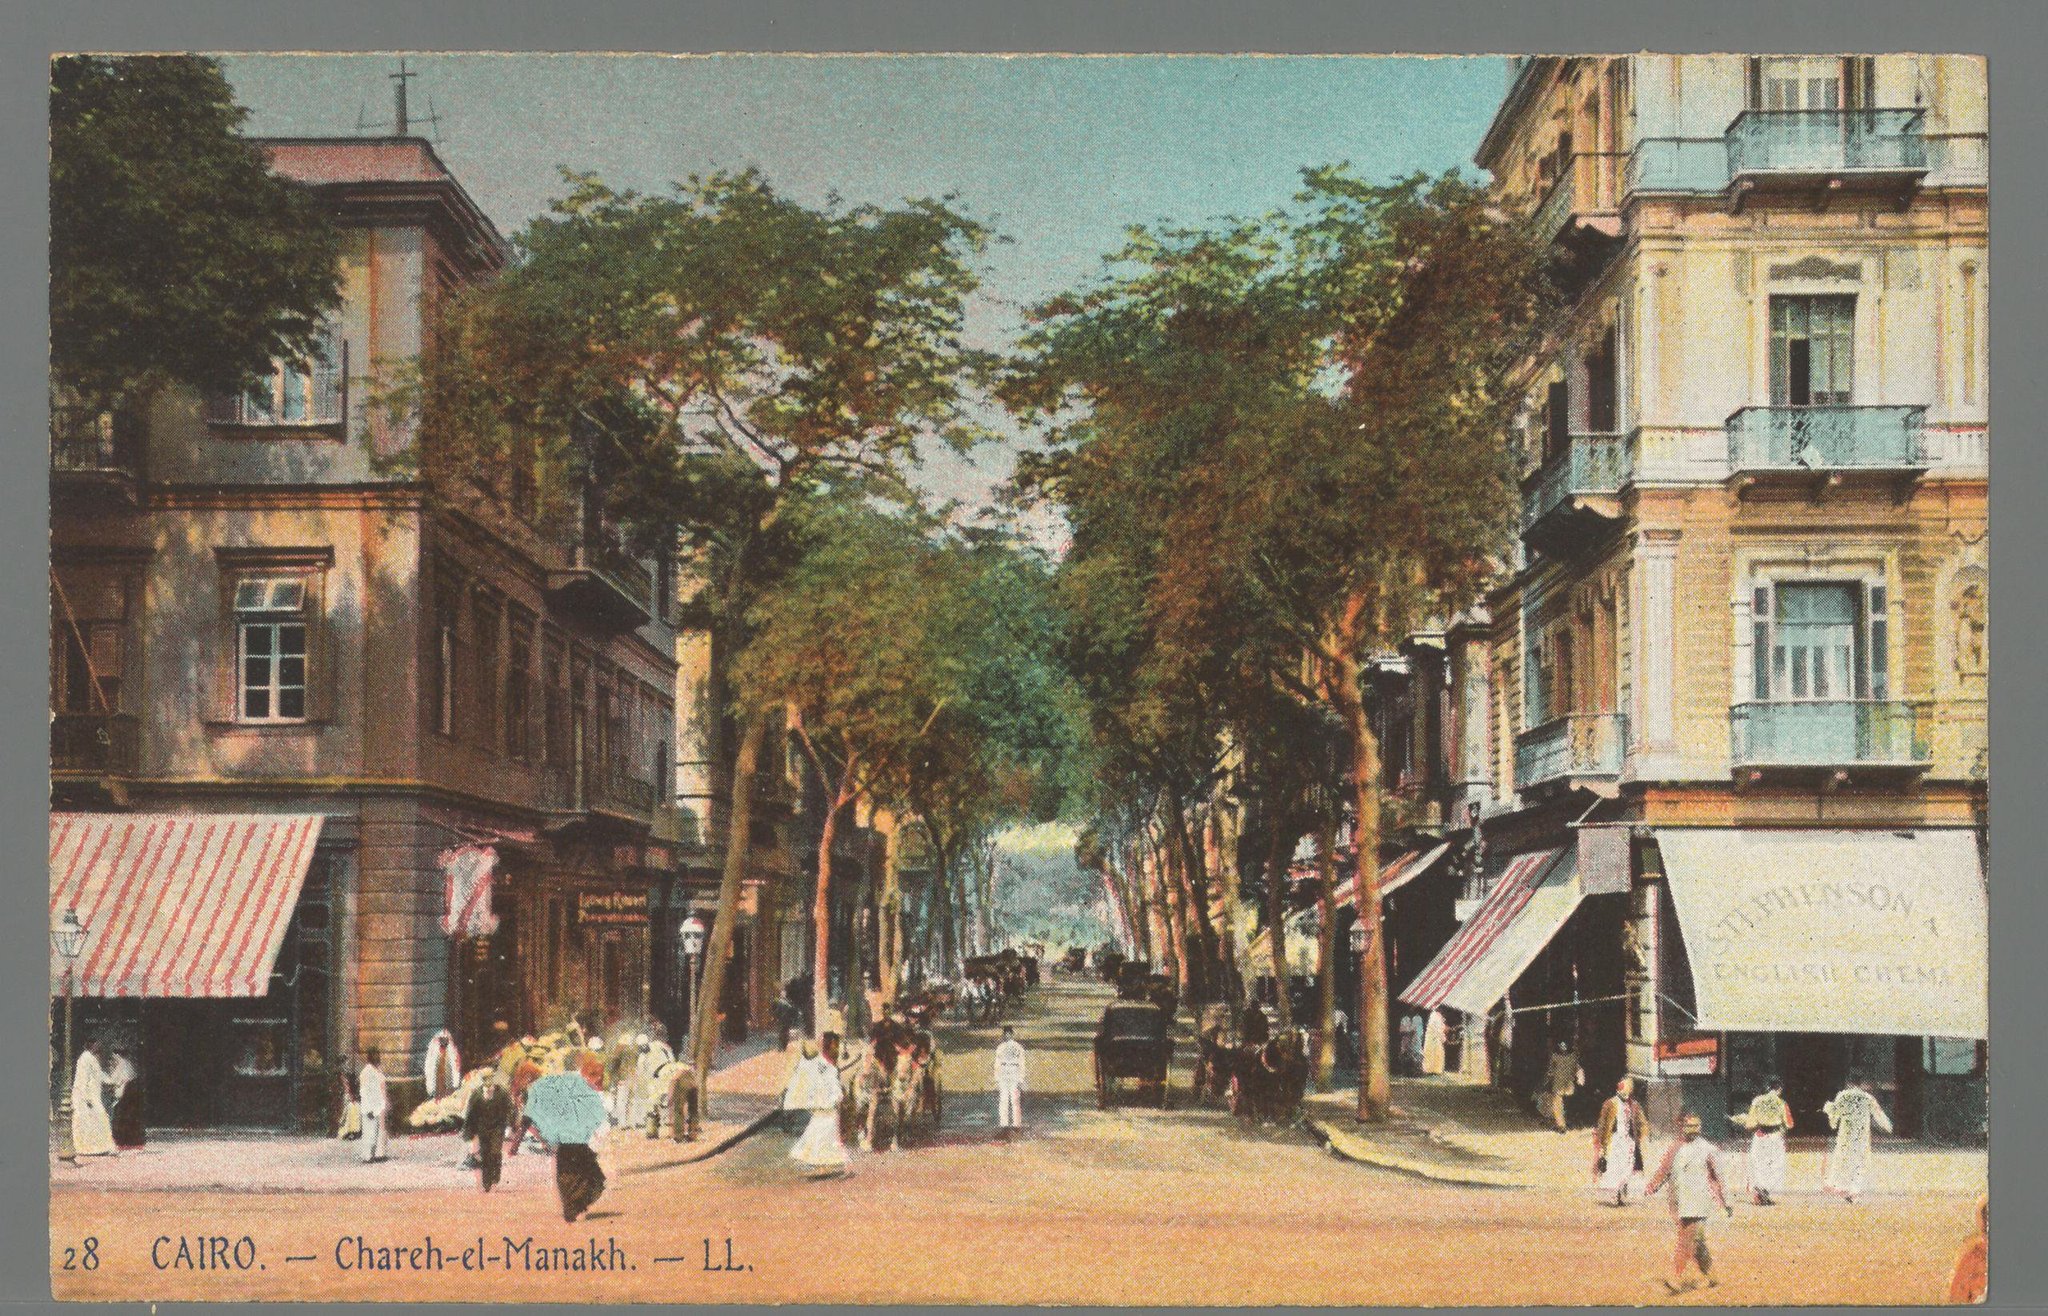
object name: photomechanical print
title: Cairo - Chareh-el-Manakh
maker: Anonymous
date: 1907-1930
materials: cardboard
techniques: lithograph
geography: paris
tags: shop, store, street